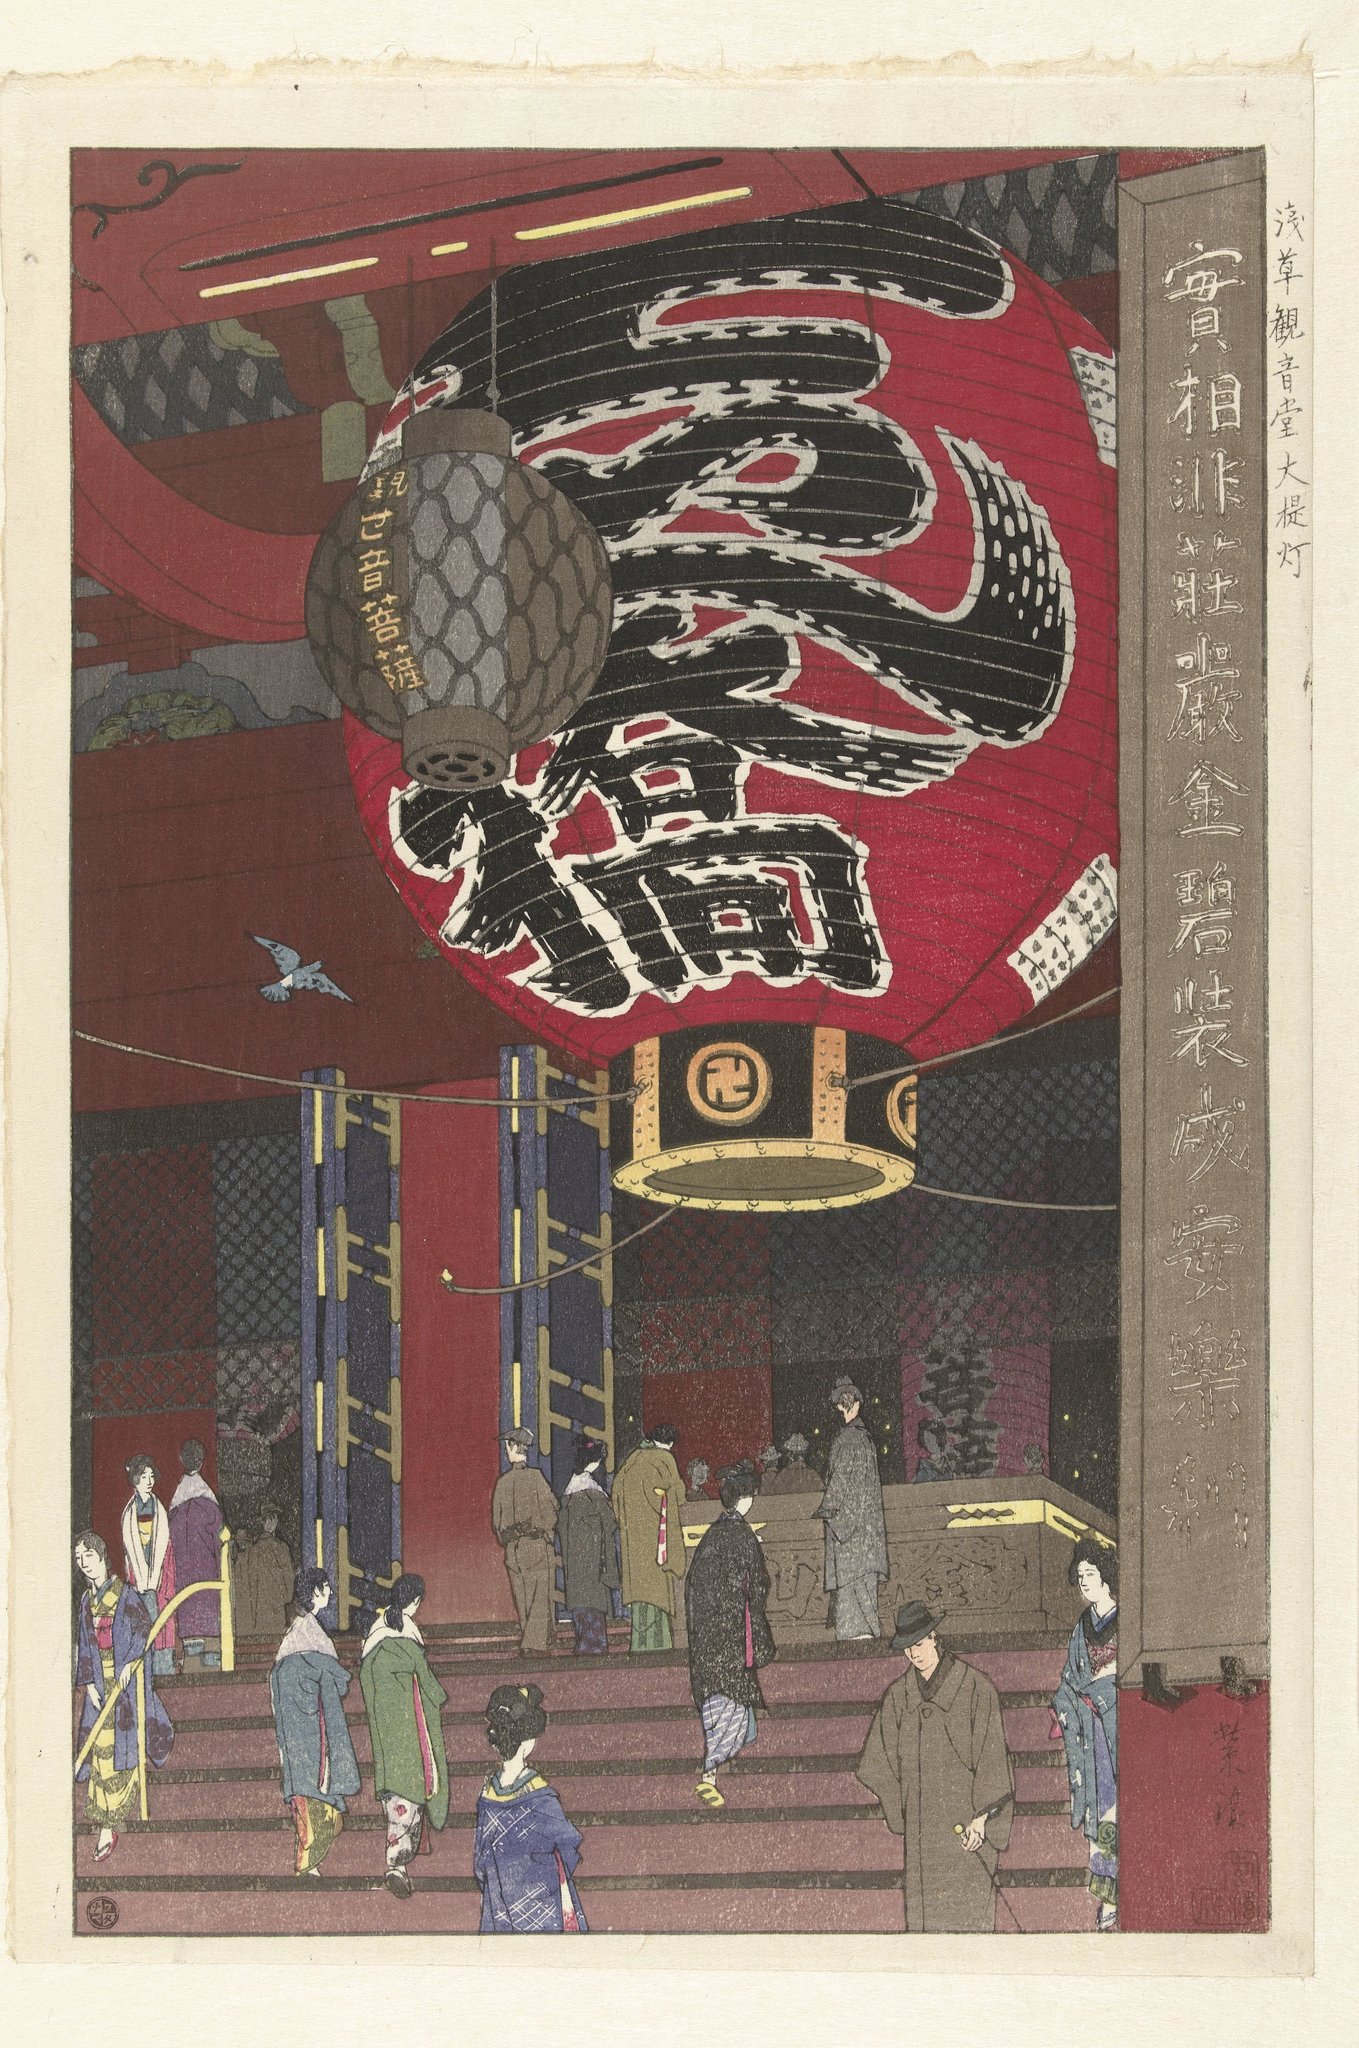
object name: print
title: De grote lantaarn van de Kannon tempel in Asakusa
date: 1934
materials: paper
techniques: woodcut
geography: japan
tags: temple, shrine ~ hinduism, buddhism, jainism, lantern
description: Gezicht op de reusachtige rode lantaarn boven de ingang van de Asakusa tempel; op de trappen verschillende tempelbezoekers.